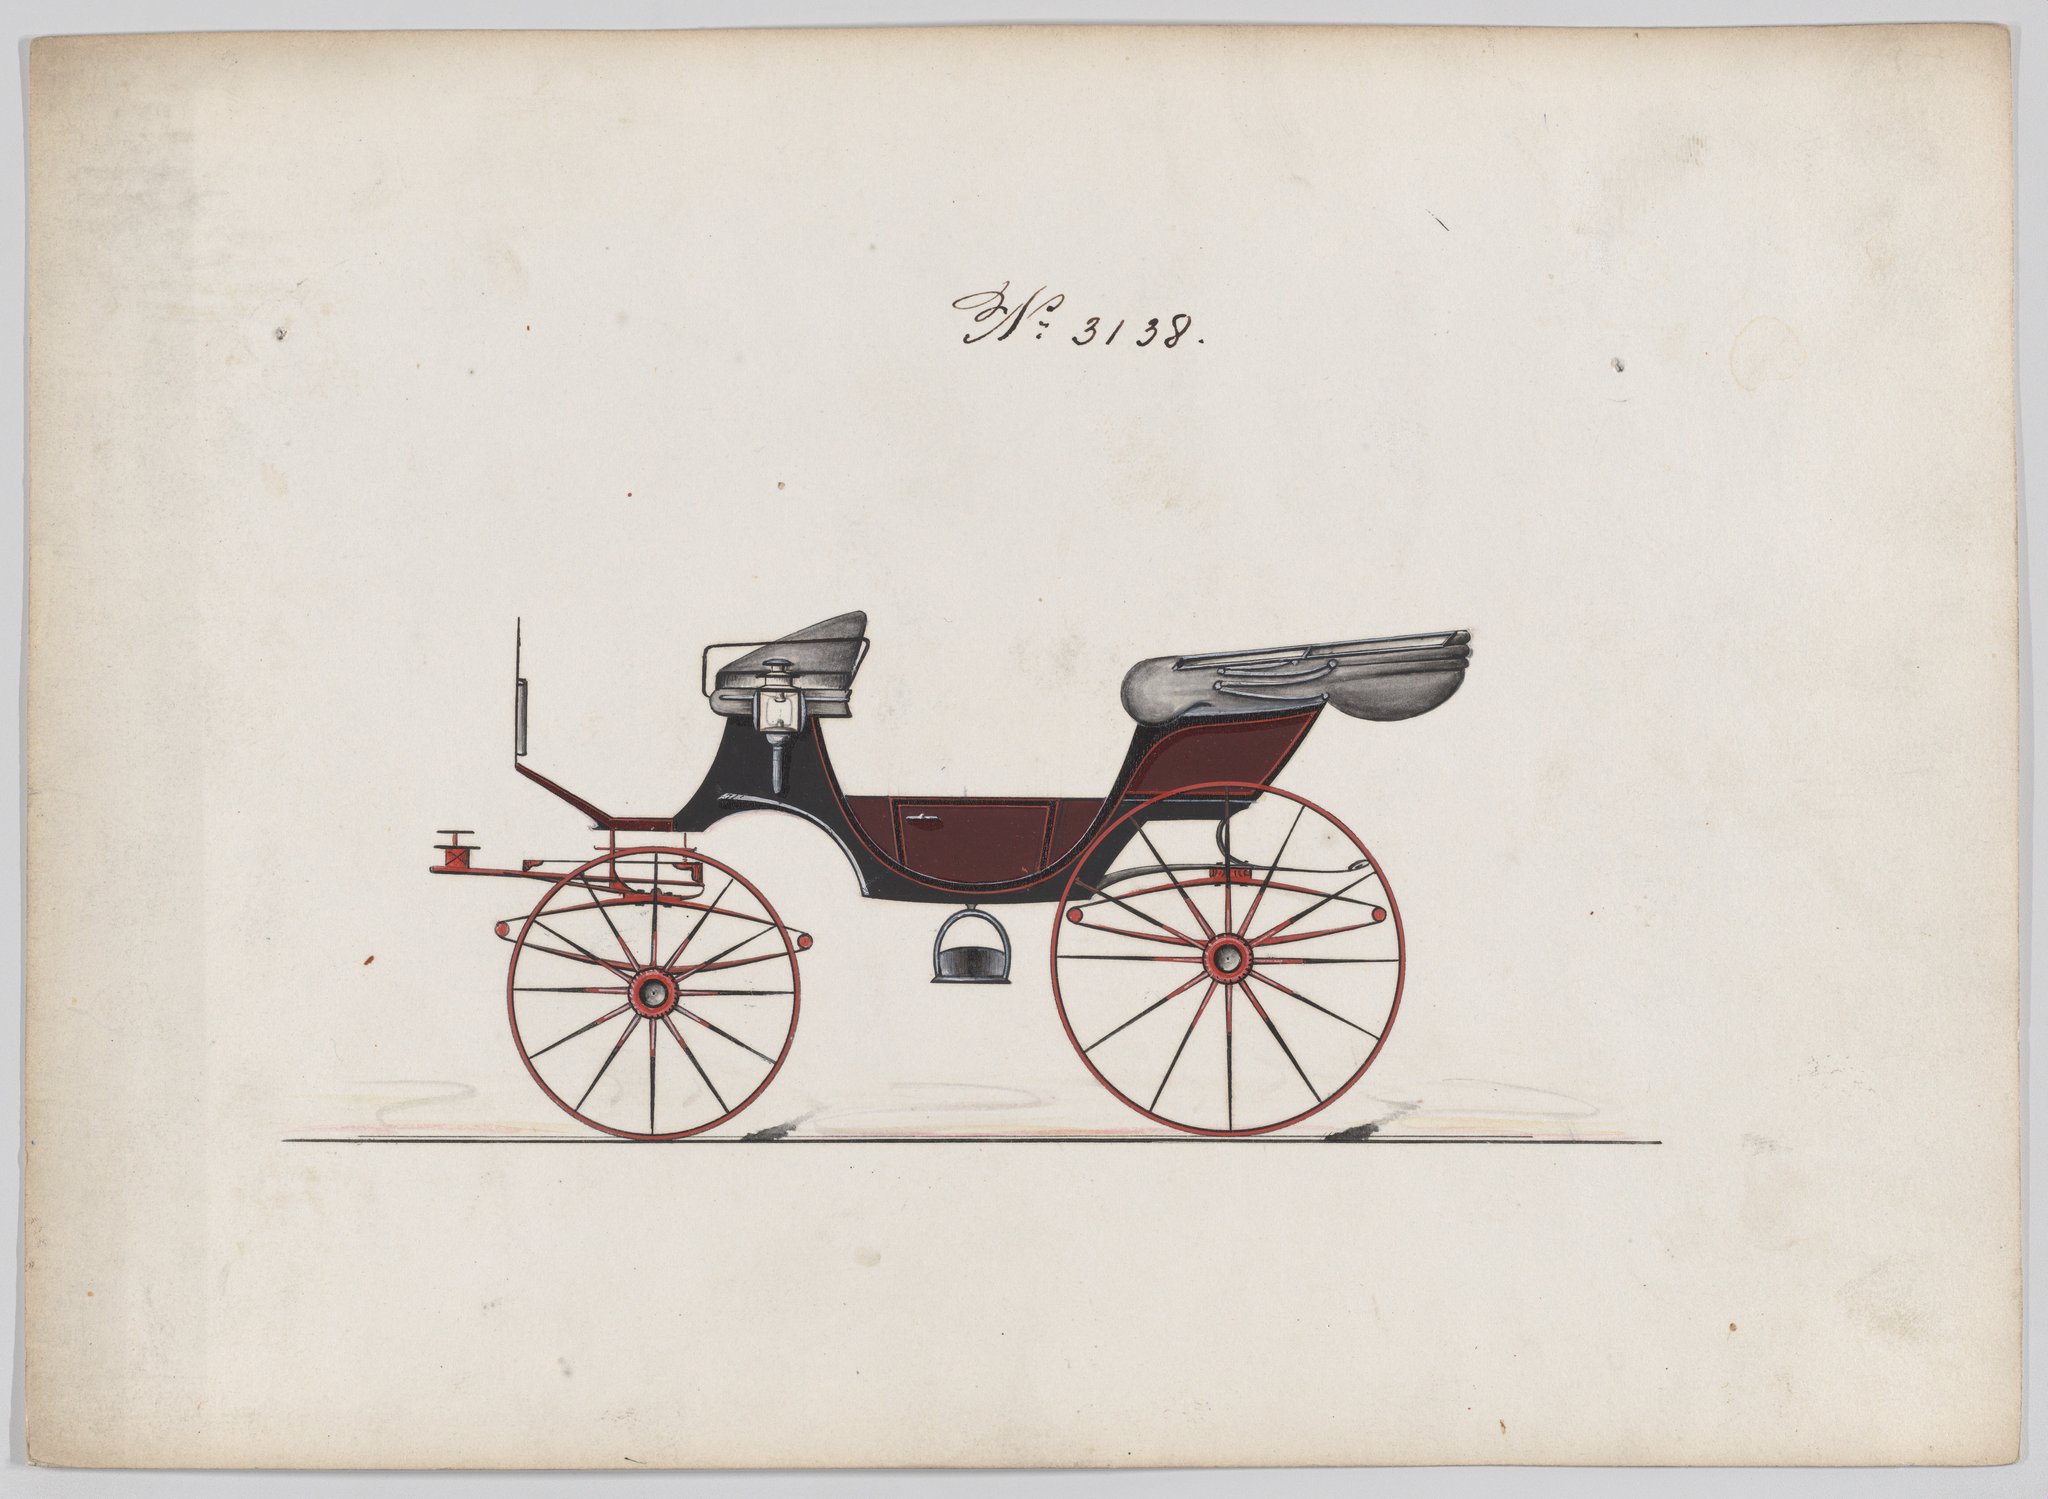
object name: drawing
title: Design for Cabriolet Phaeton, no. 3138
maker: brewster & co.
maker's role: manufacturer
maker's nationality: american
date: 1875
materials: gouache, ink, watercolor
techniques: pen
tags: carriages